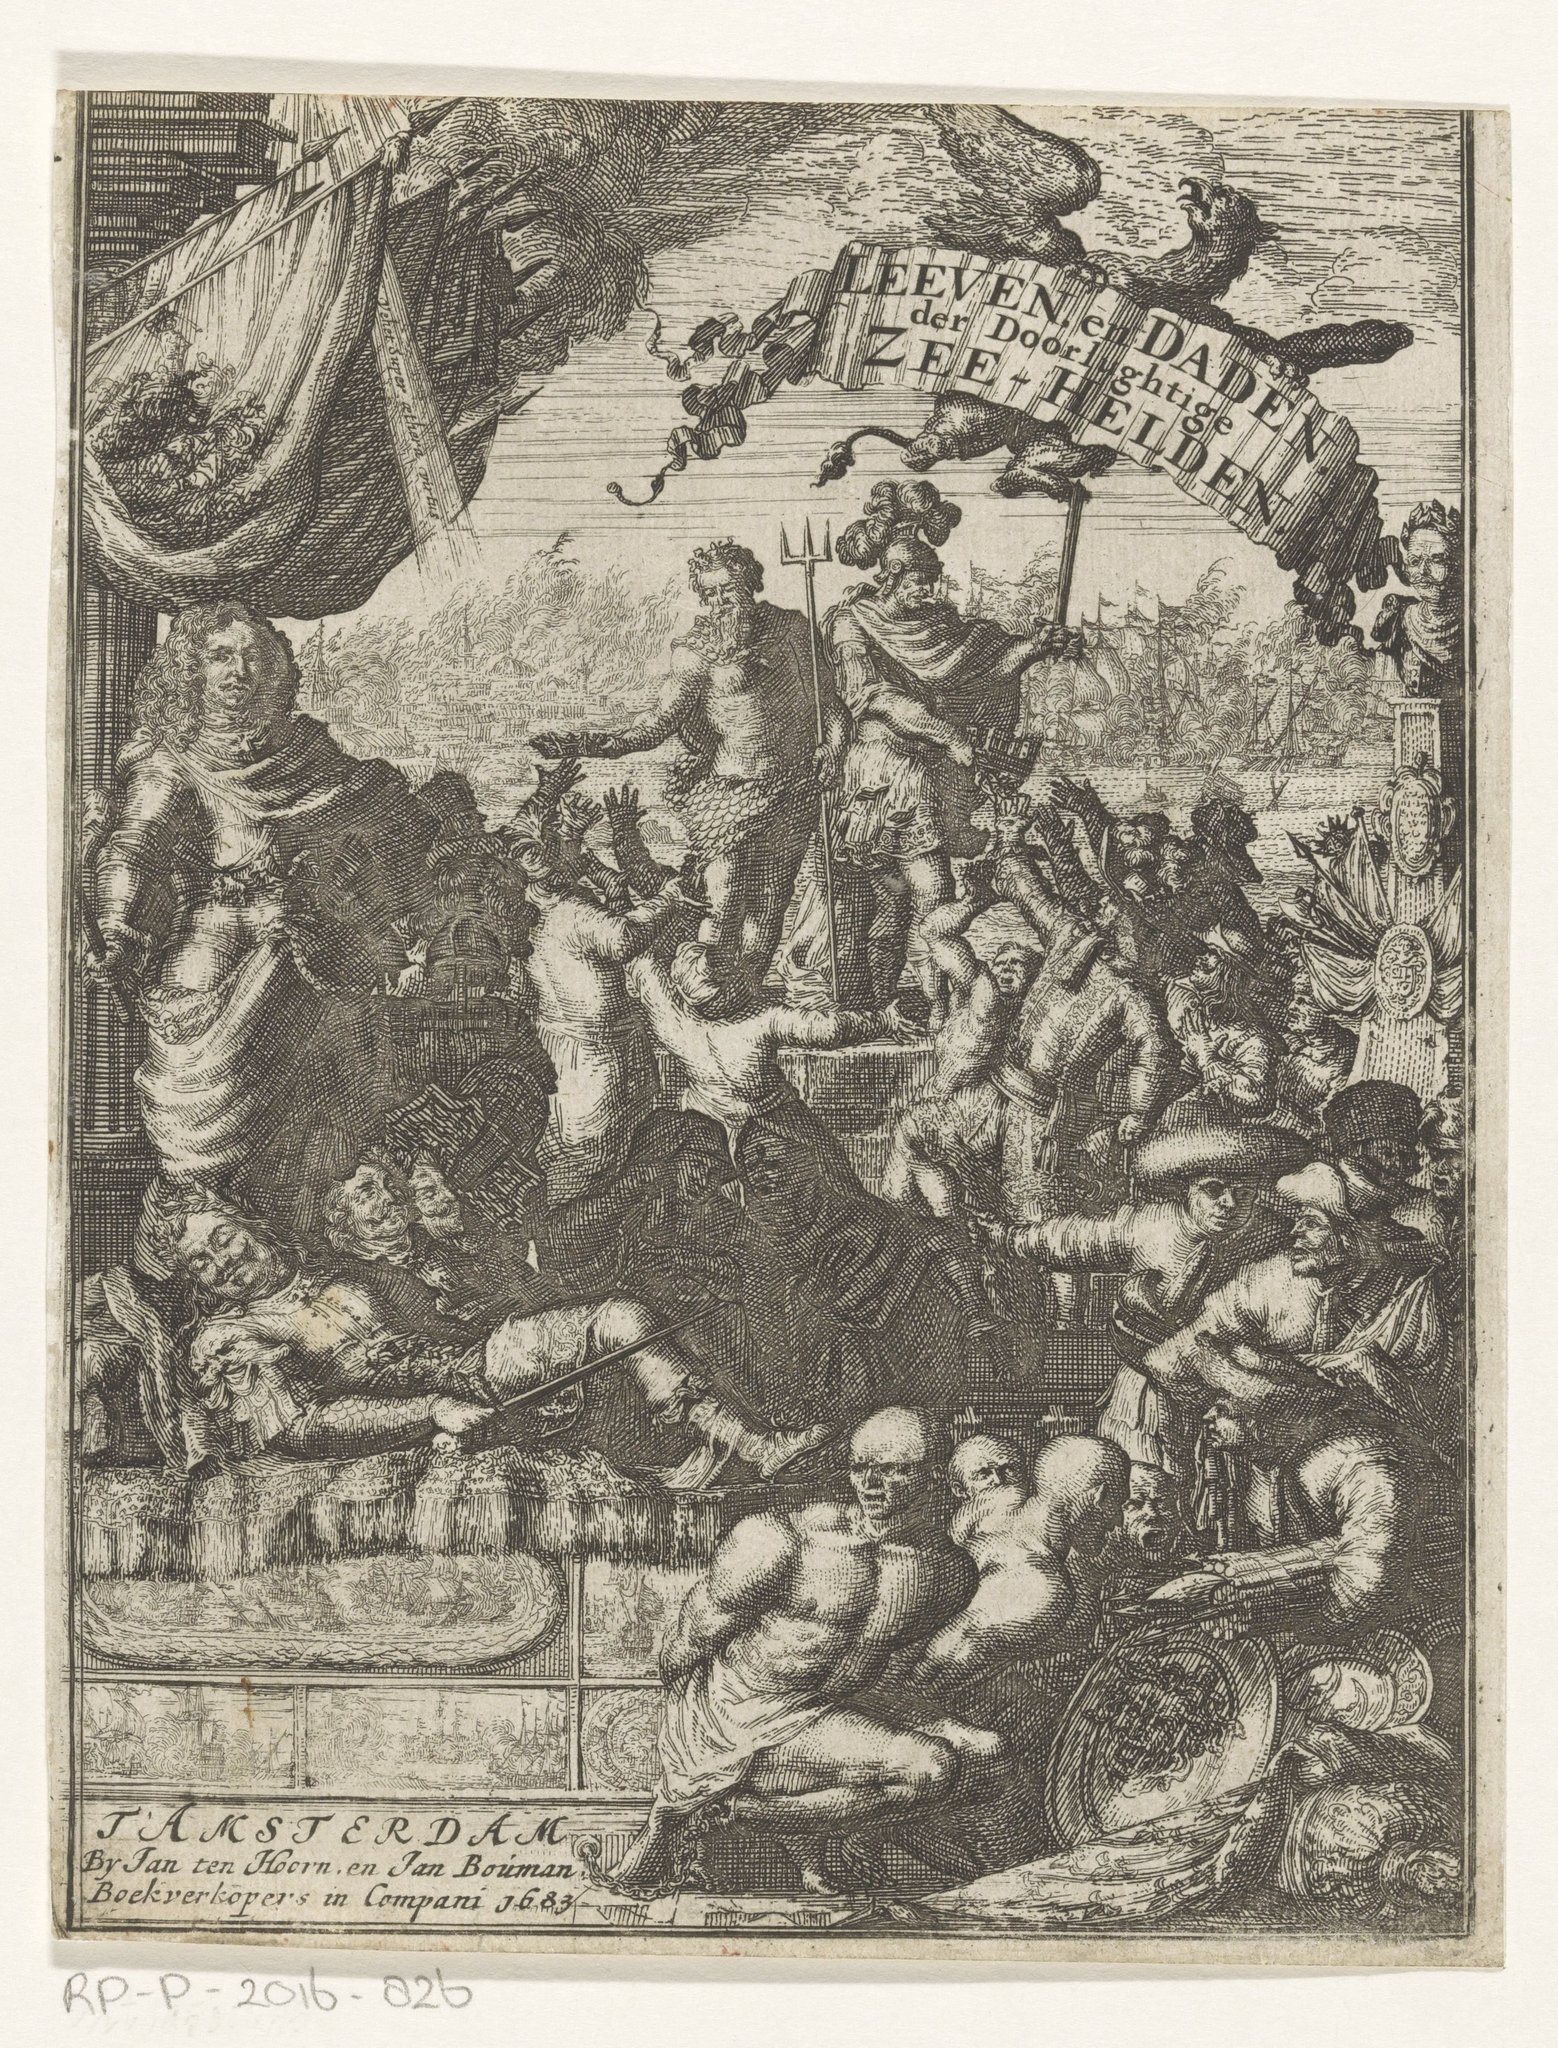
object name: print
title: Triomf van gezagvoerders ter zee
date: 1683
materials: paper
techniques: etching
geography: amsterdam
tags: michiel adriaenszoon de ruyter, (story of) neptune (poseidon), commander-in-chief, admiral (+ naval force)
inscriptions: collector's mark: Lugt 2228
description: Neptunus en een man in harnas delen (steden)kronen uit aan een groep omstanders. Rechts staat een groep mannen met geketende kale mannen en wapens. Links wenen vrouwen bij gestorven gezagvoerders ter zee, onder andere Michiel Adriaenszoon de Ruyter. Links staat een man met commandostaf. In de achtergrond zeeslagen.